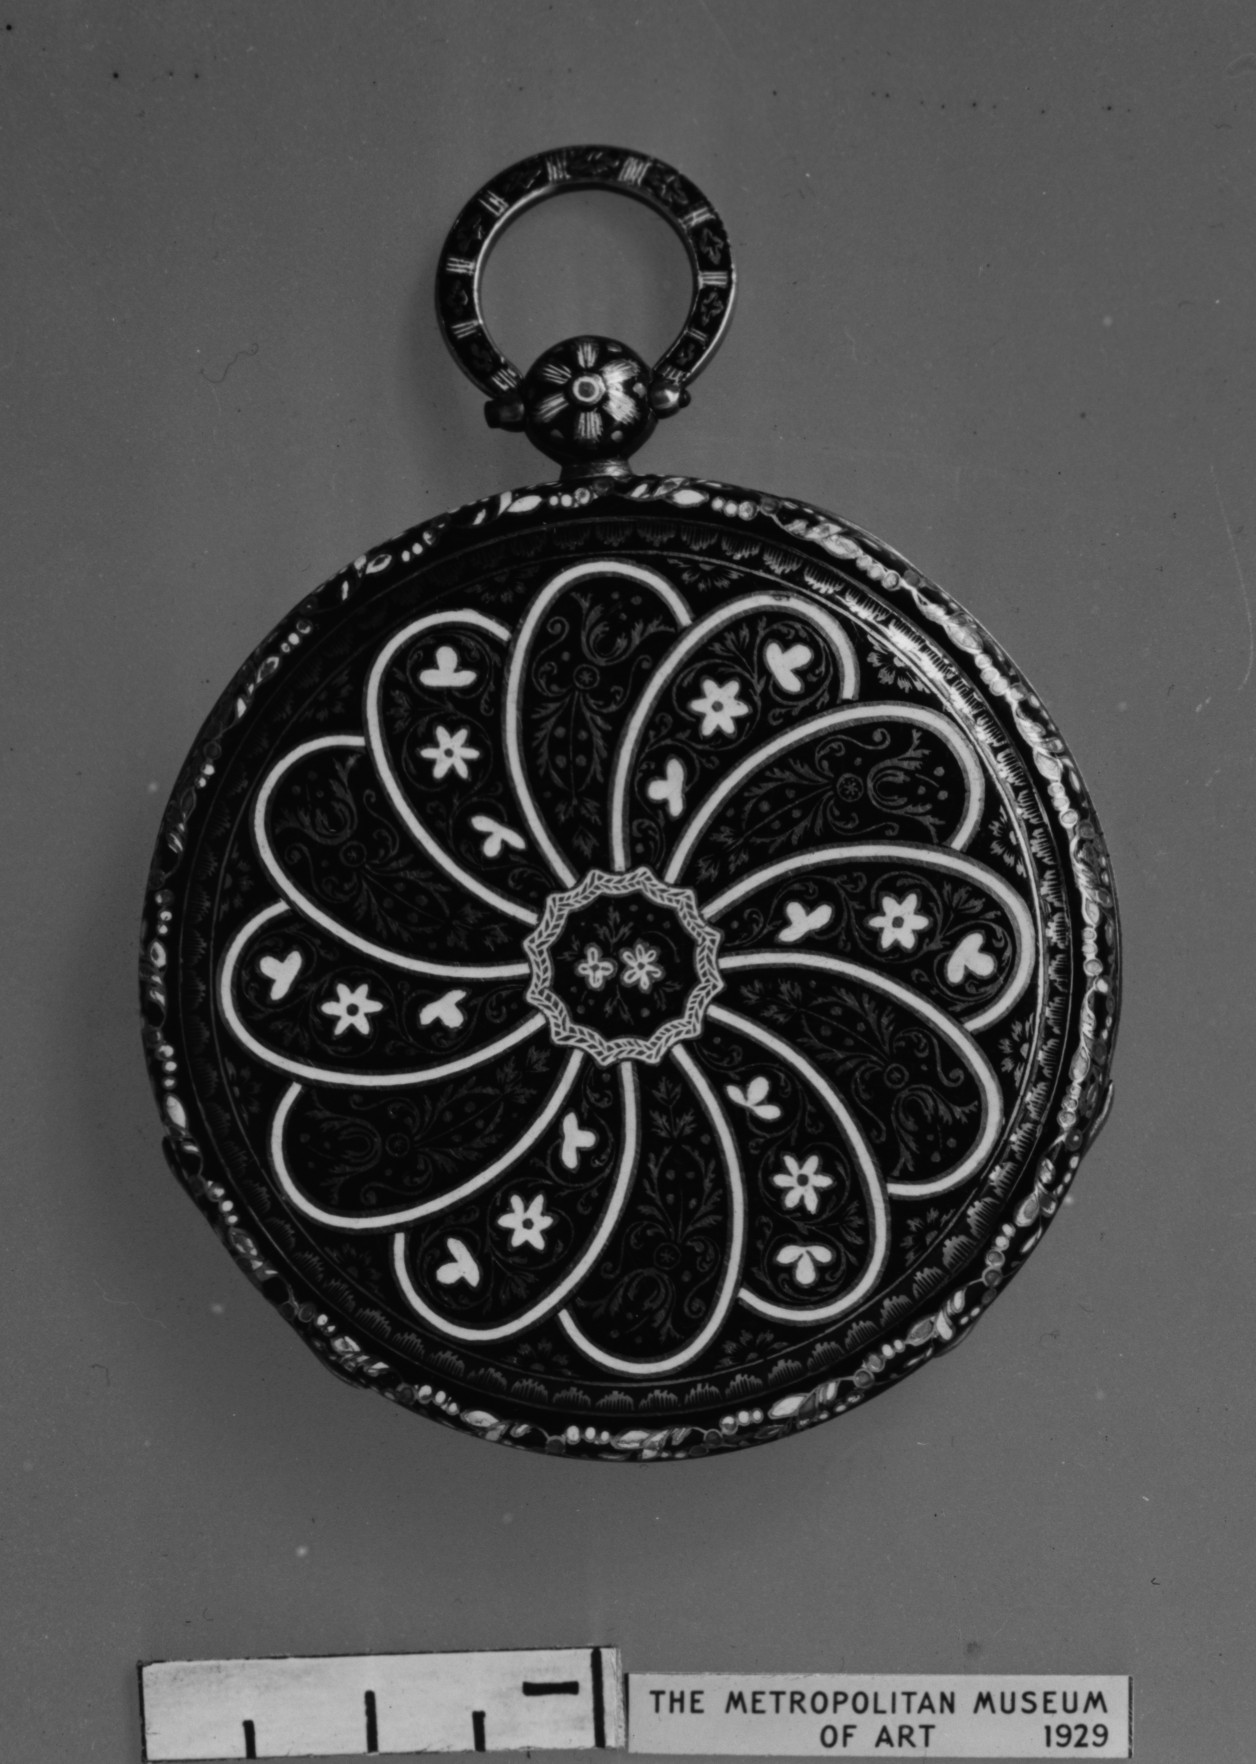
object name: watch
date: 1815-1820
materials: enamel, gold